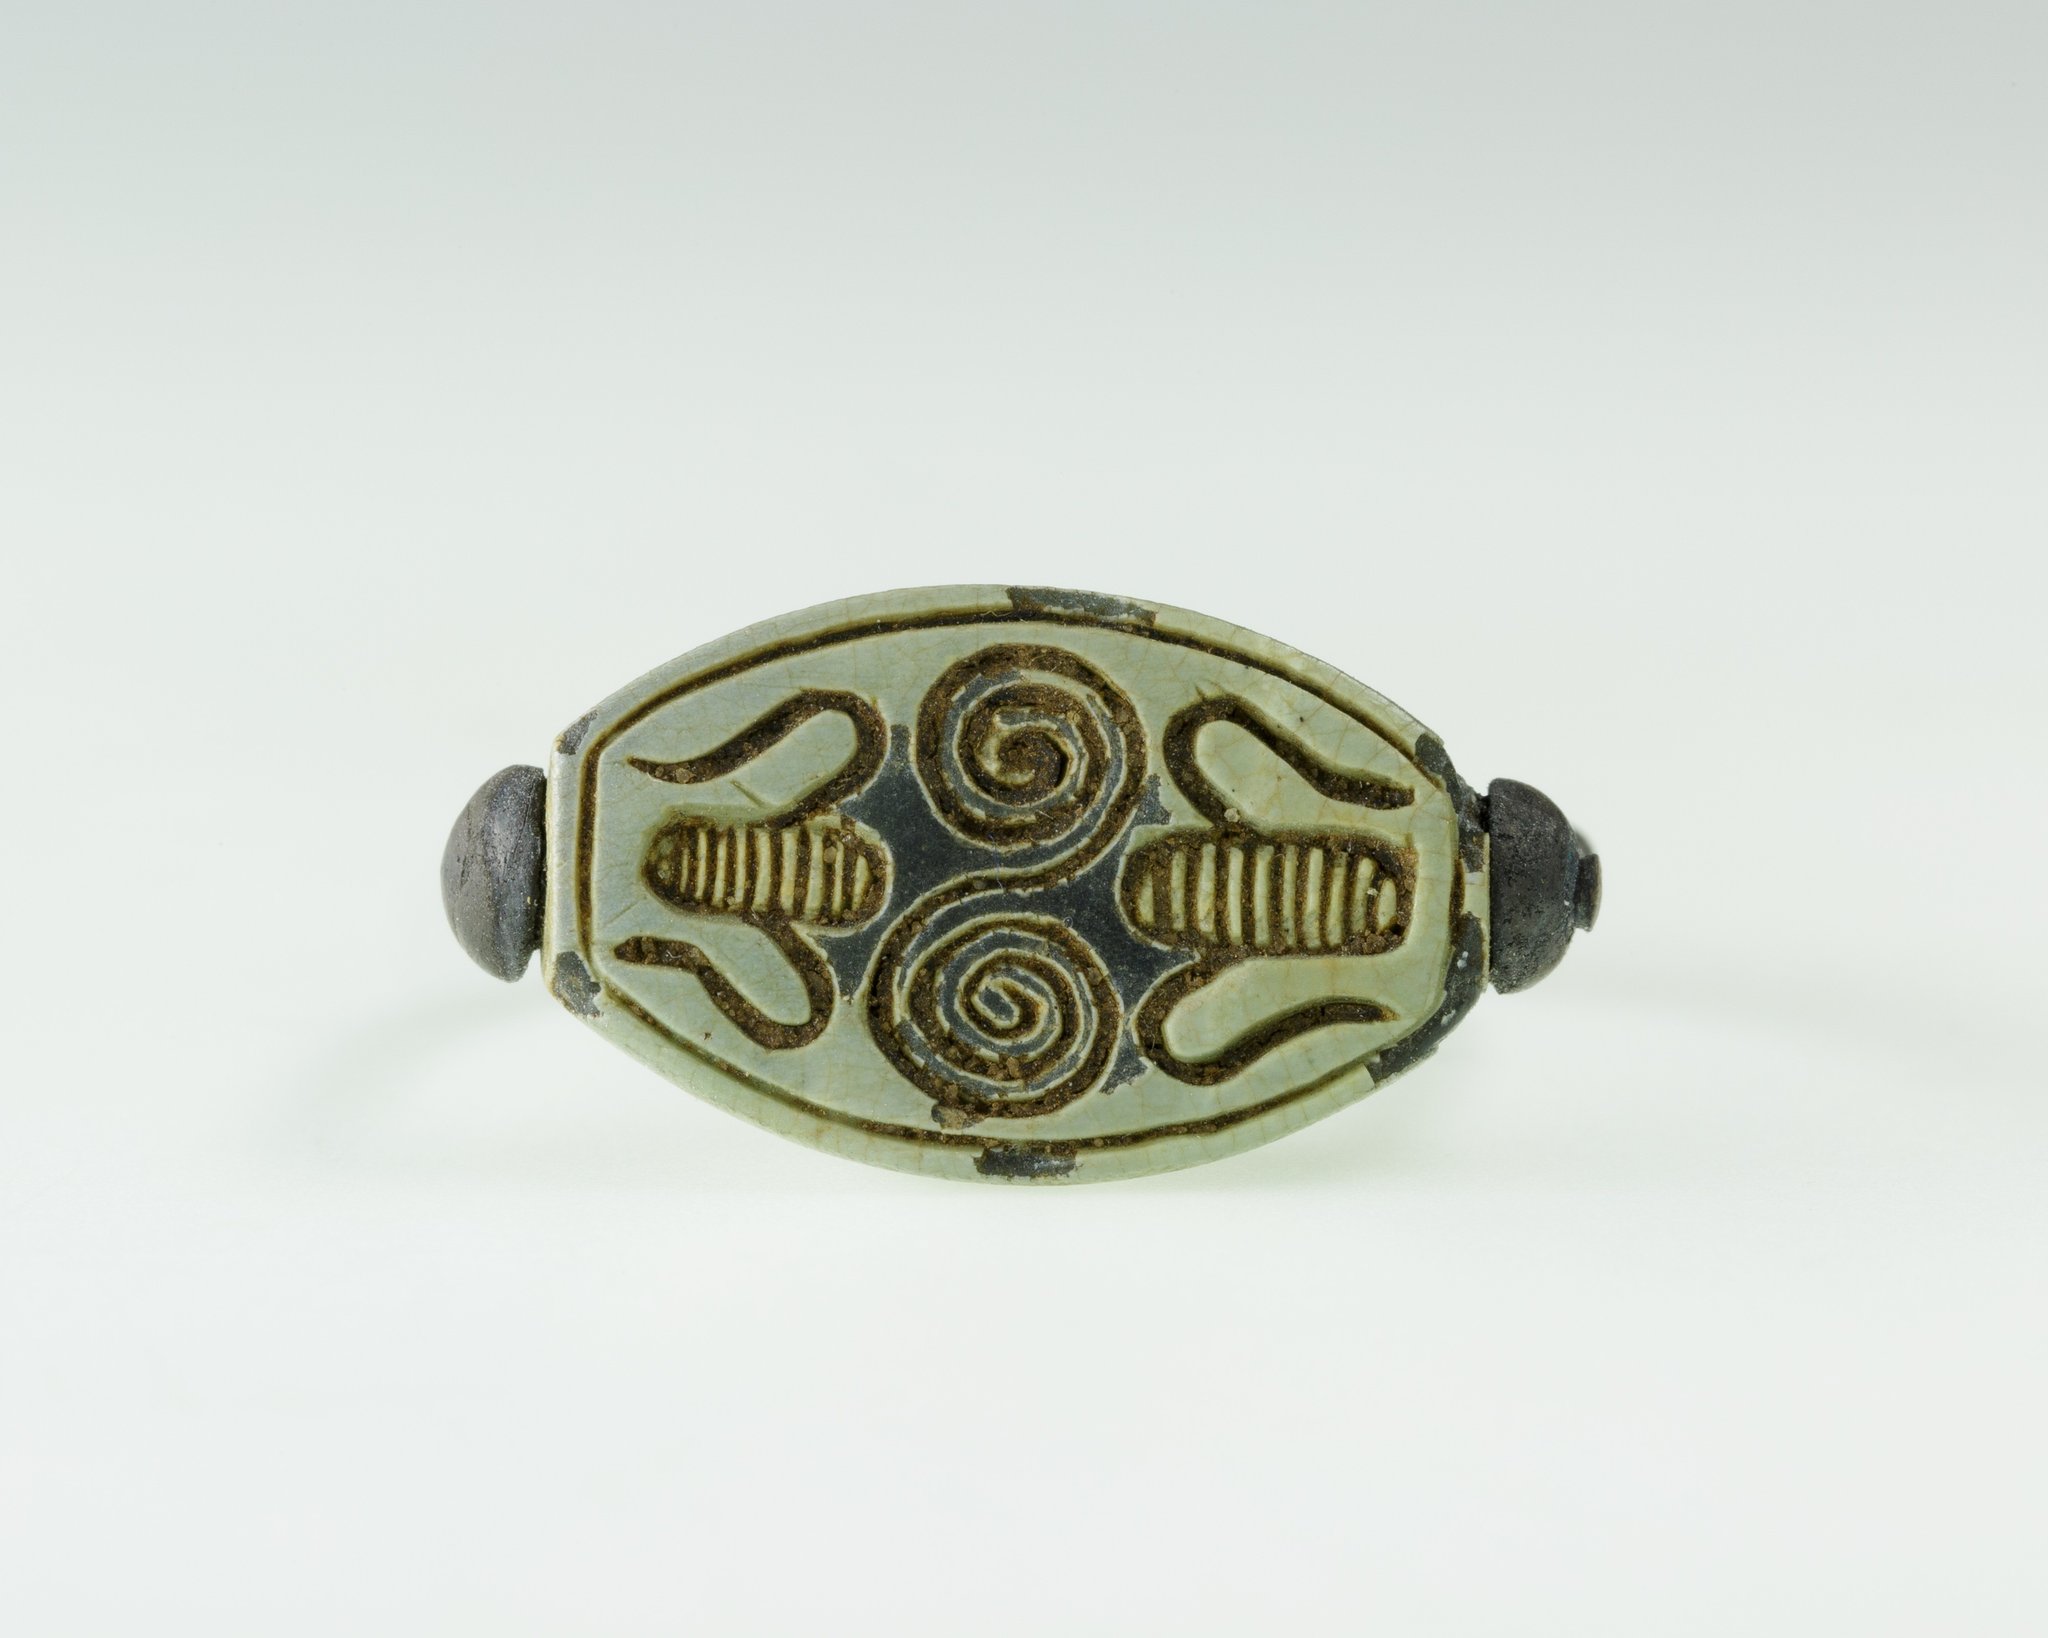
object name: ring, cowroid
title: Ring of Hatnefer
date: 1492-1473 BCE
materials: silver, stone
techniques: glazing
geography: egypt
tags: insects,scarabs